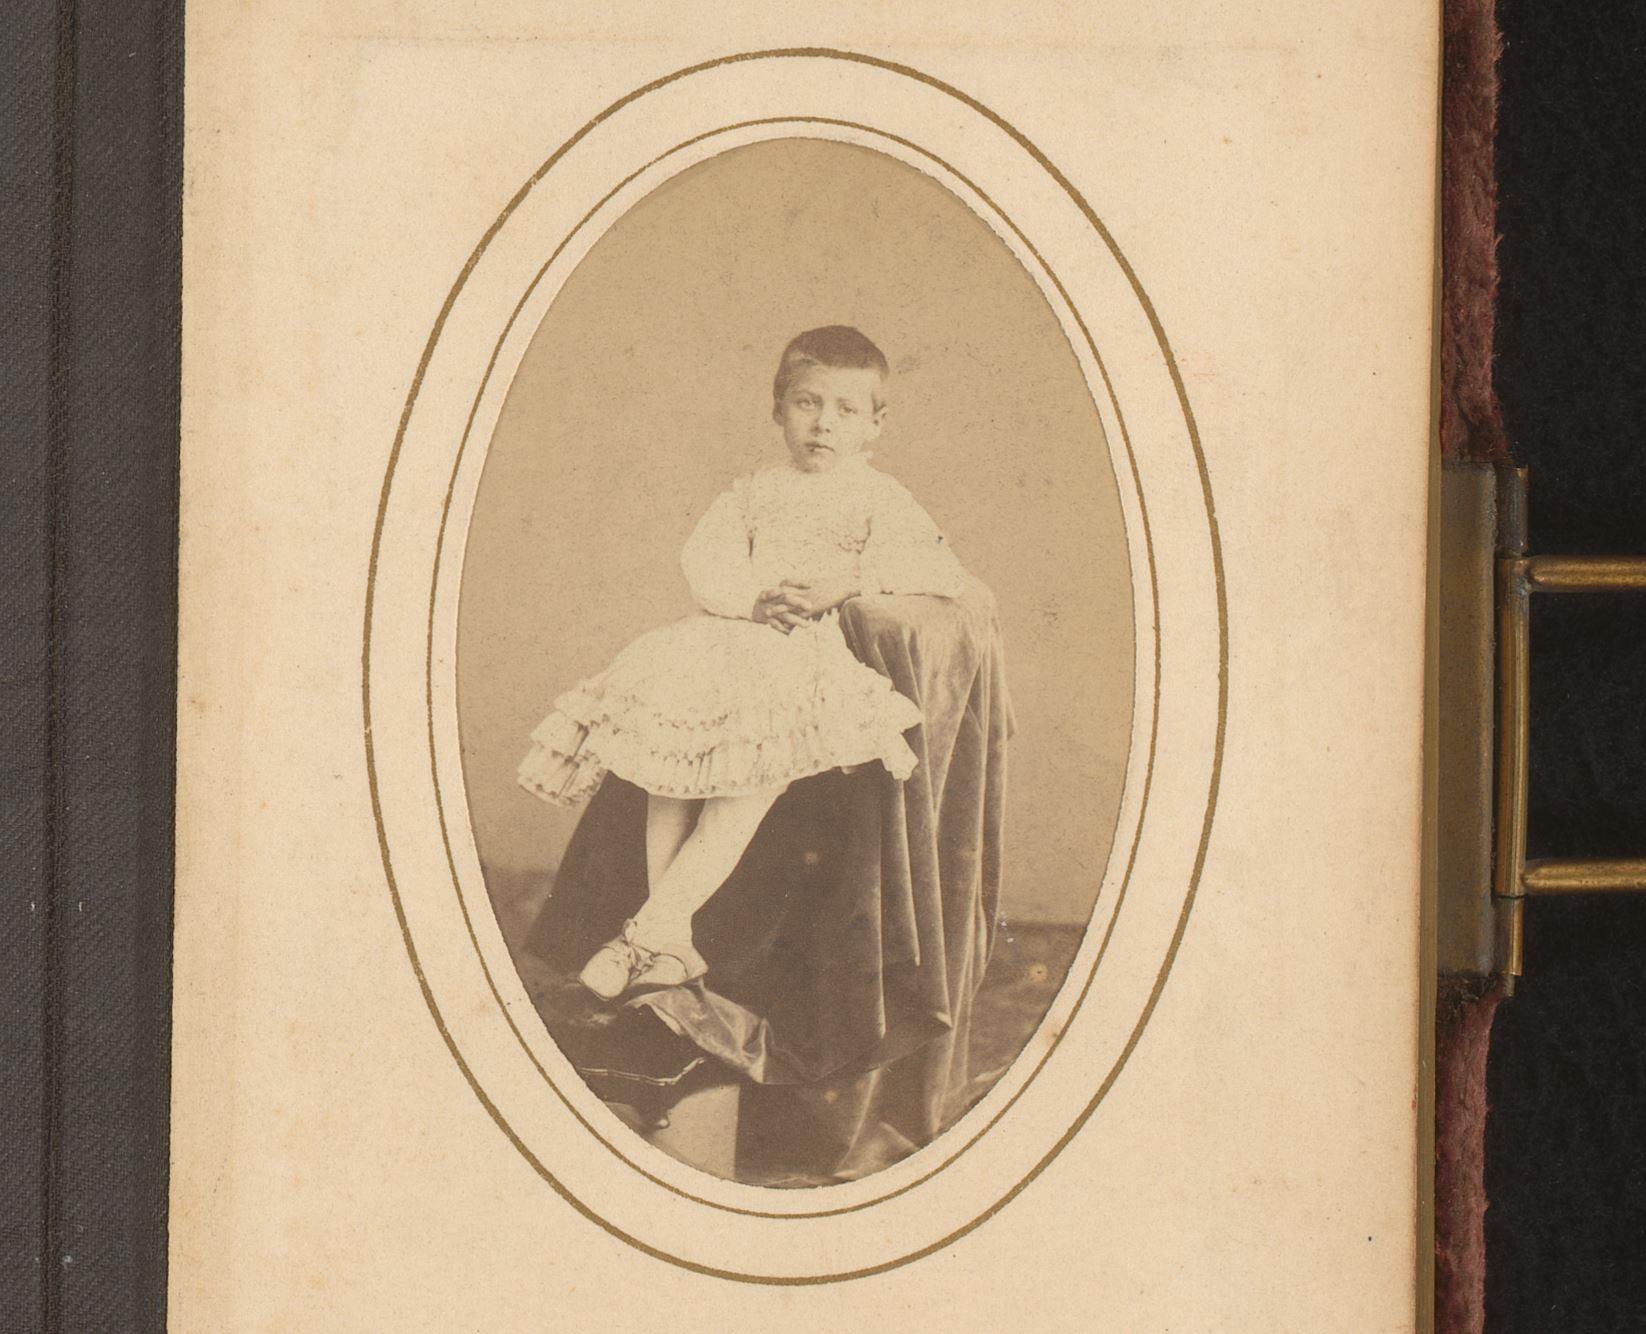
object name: photograph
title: Portret van een kind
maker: antoine rené trinquart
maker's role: fotograaf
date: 1860-1900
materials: cardboard, photographic support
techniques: albumen print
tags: sitting figure, child, historical persons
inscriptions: annotation: ‘??’, inscription: ‘Trinquart/ Breveté/ 23, Rue Louis le Grand, 23/ Paris’